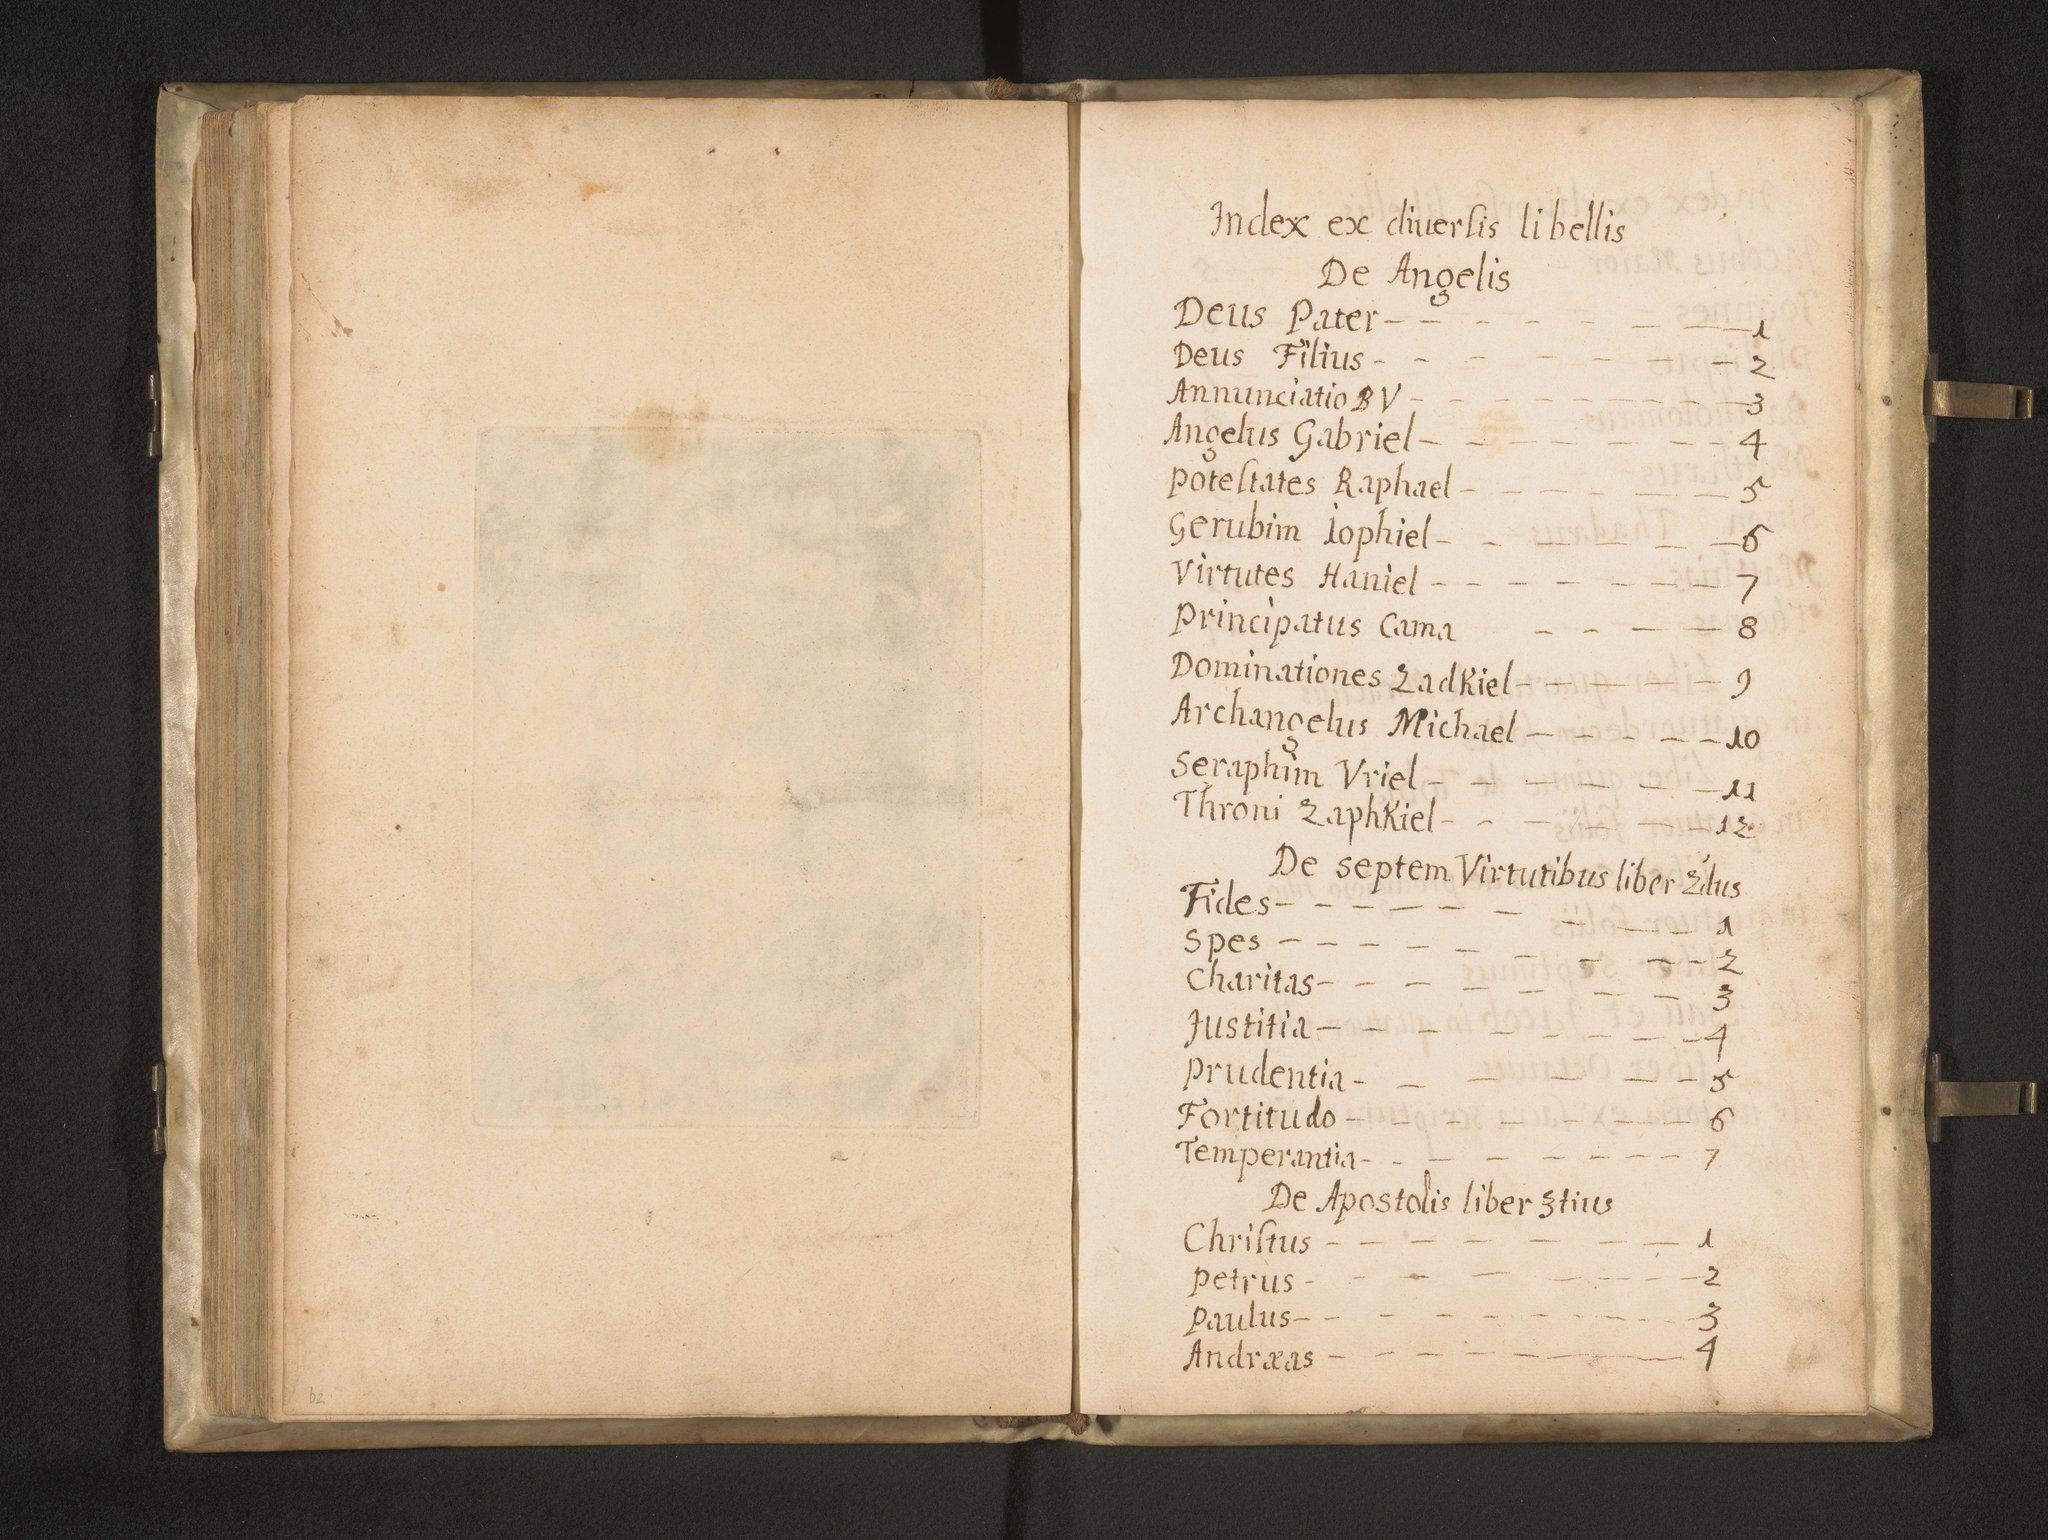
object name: manuscript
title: Index op het prentenalbum (recto)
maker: Anonymous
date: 1670-1699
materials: ink, paper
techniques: handwriting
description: Handgeschreven inhoudsopgave van het prentenalbum (recto). Onderdeel van een album met voornamelijk christelijke voorstellingen.